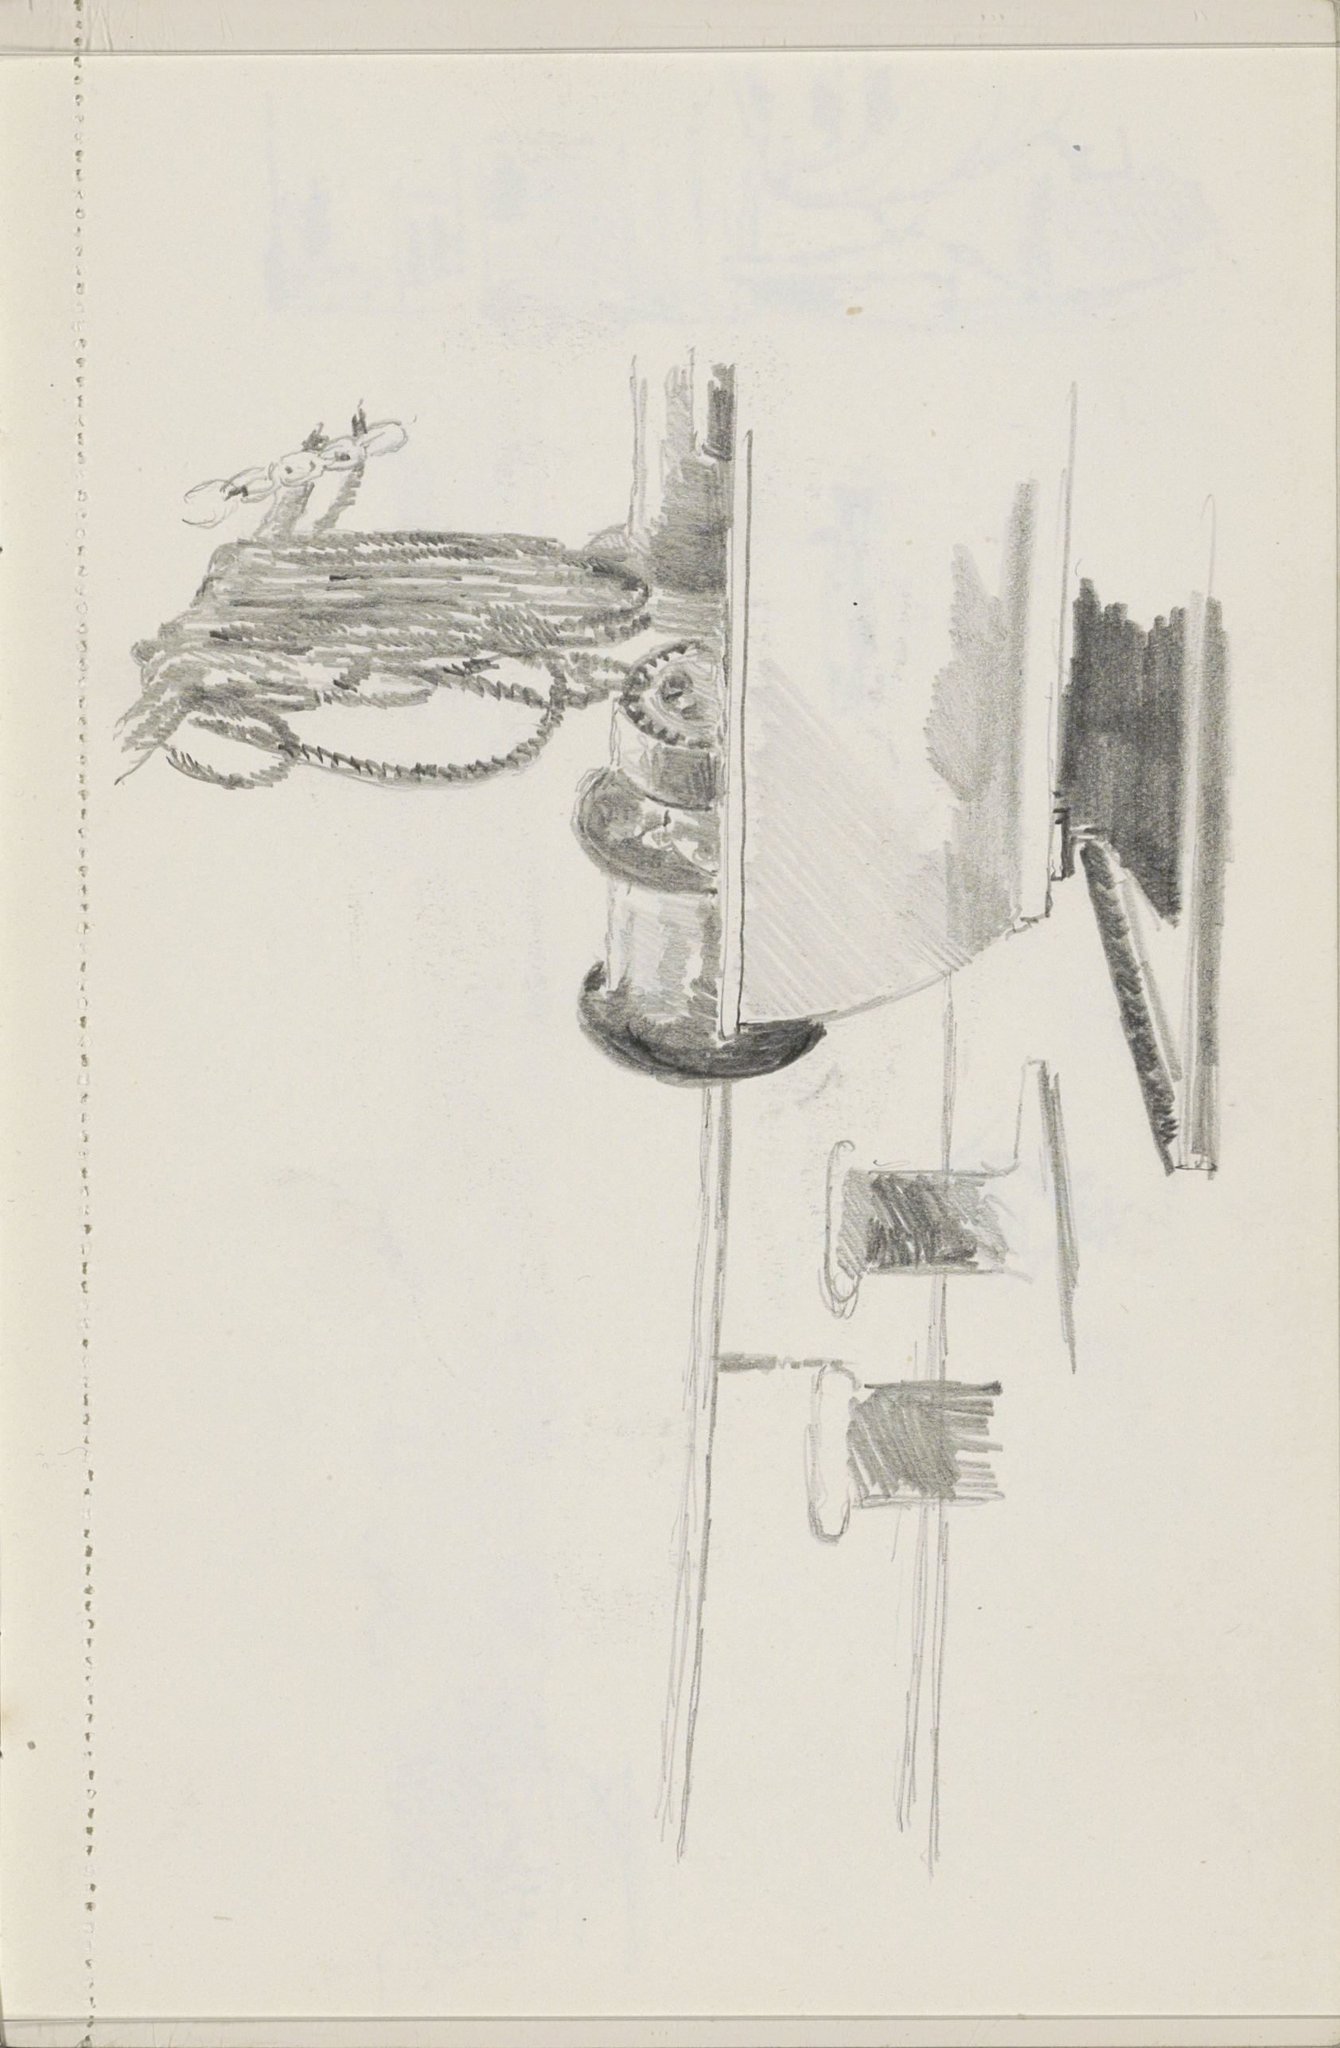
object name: sketchbook leaf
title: Reddingssloep op het dek van een schip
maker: cornelis vreedenburgh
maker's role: draughtsman, print maker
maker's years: 1880-1946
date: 1935-1936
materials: paper, pencil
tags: parts of ship's exterior: deck, lifeboat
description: Blad 56 recto uit een schetsboek met 73 bladen.